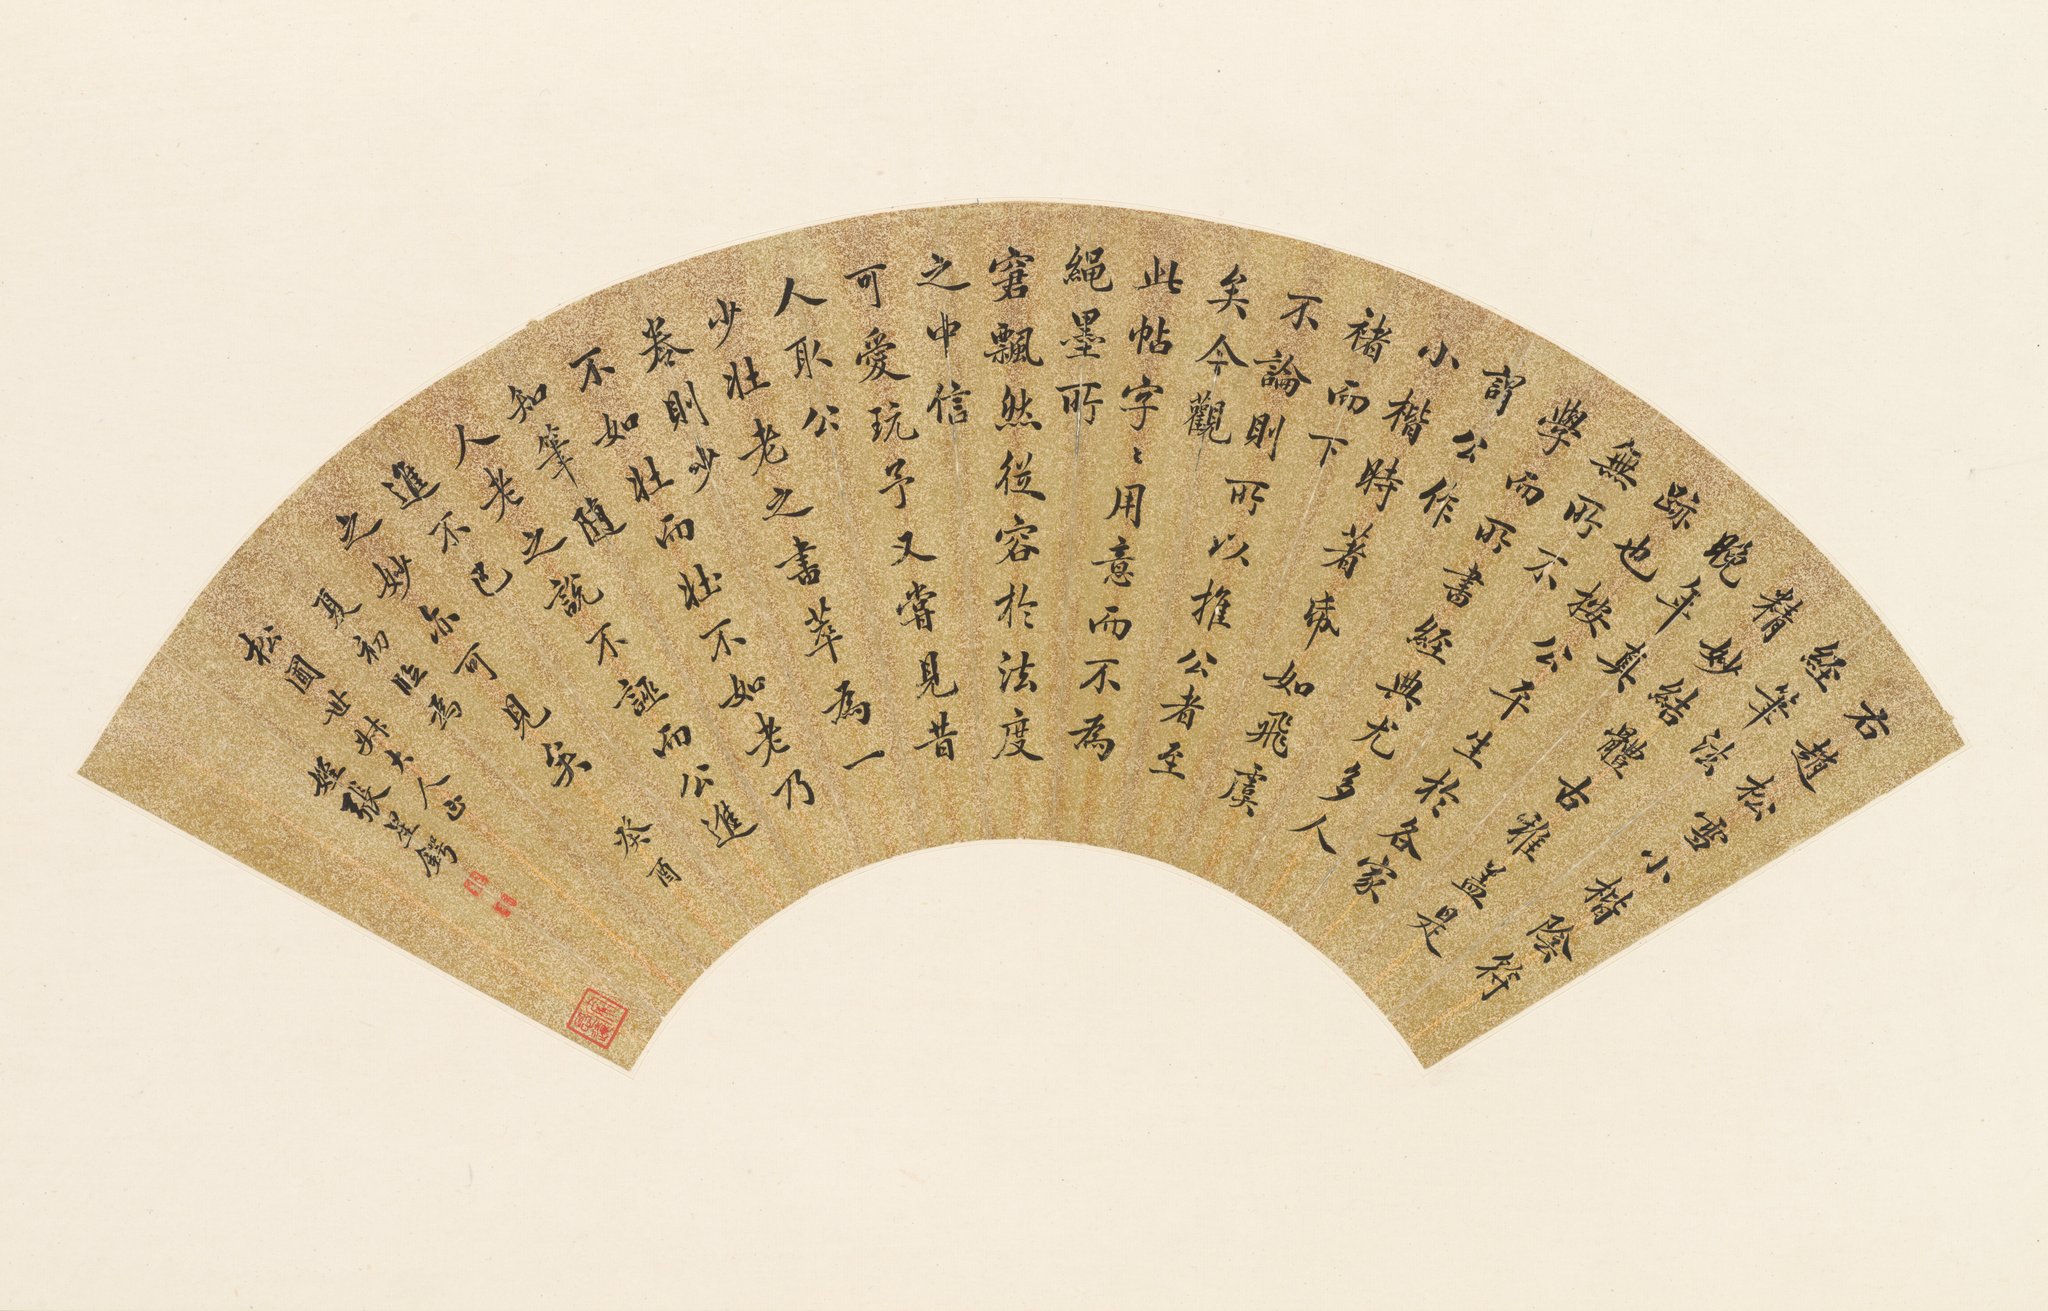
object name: folding fan mounted a an album leaf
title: Transcription of a Colophon to a Calligraphy by Zhao Mengfu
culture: chinese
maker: zhang xinge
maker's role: artist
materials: gold, ink, paper